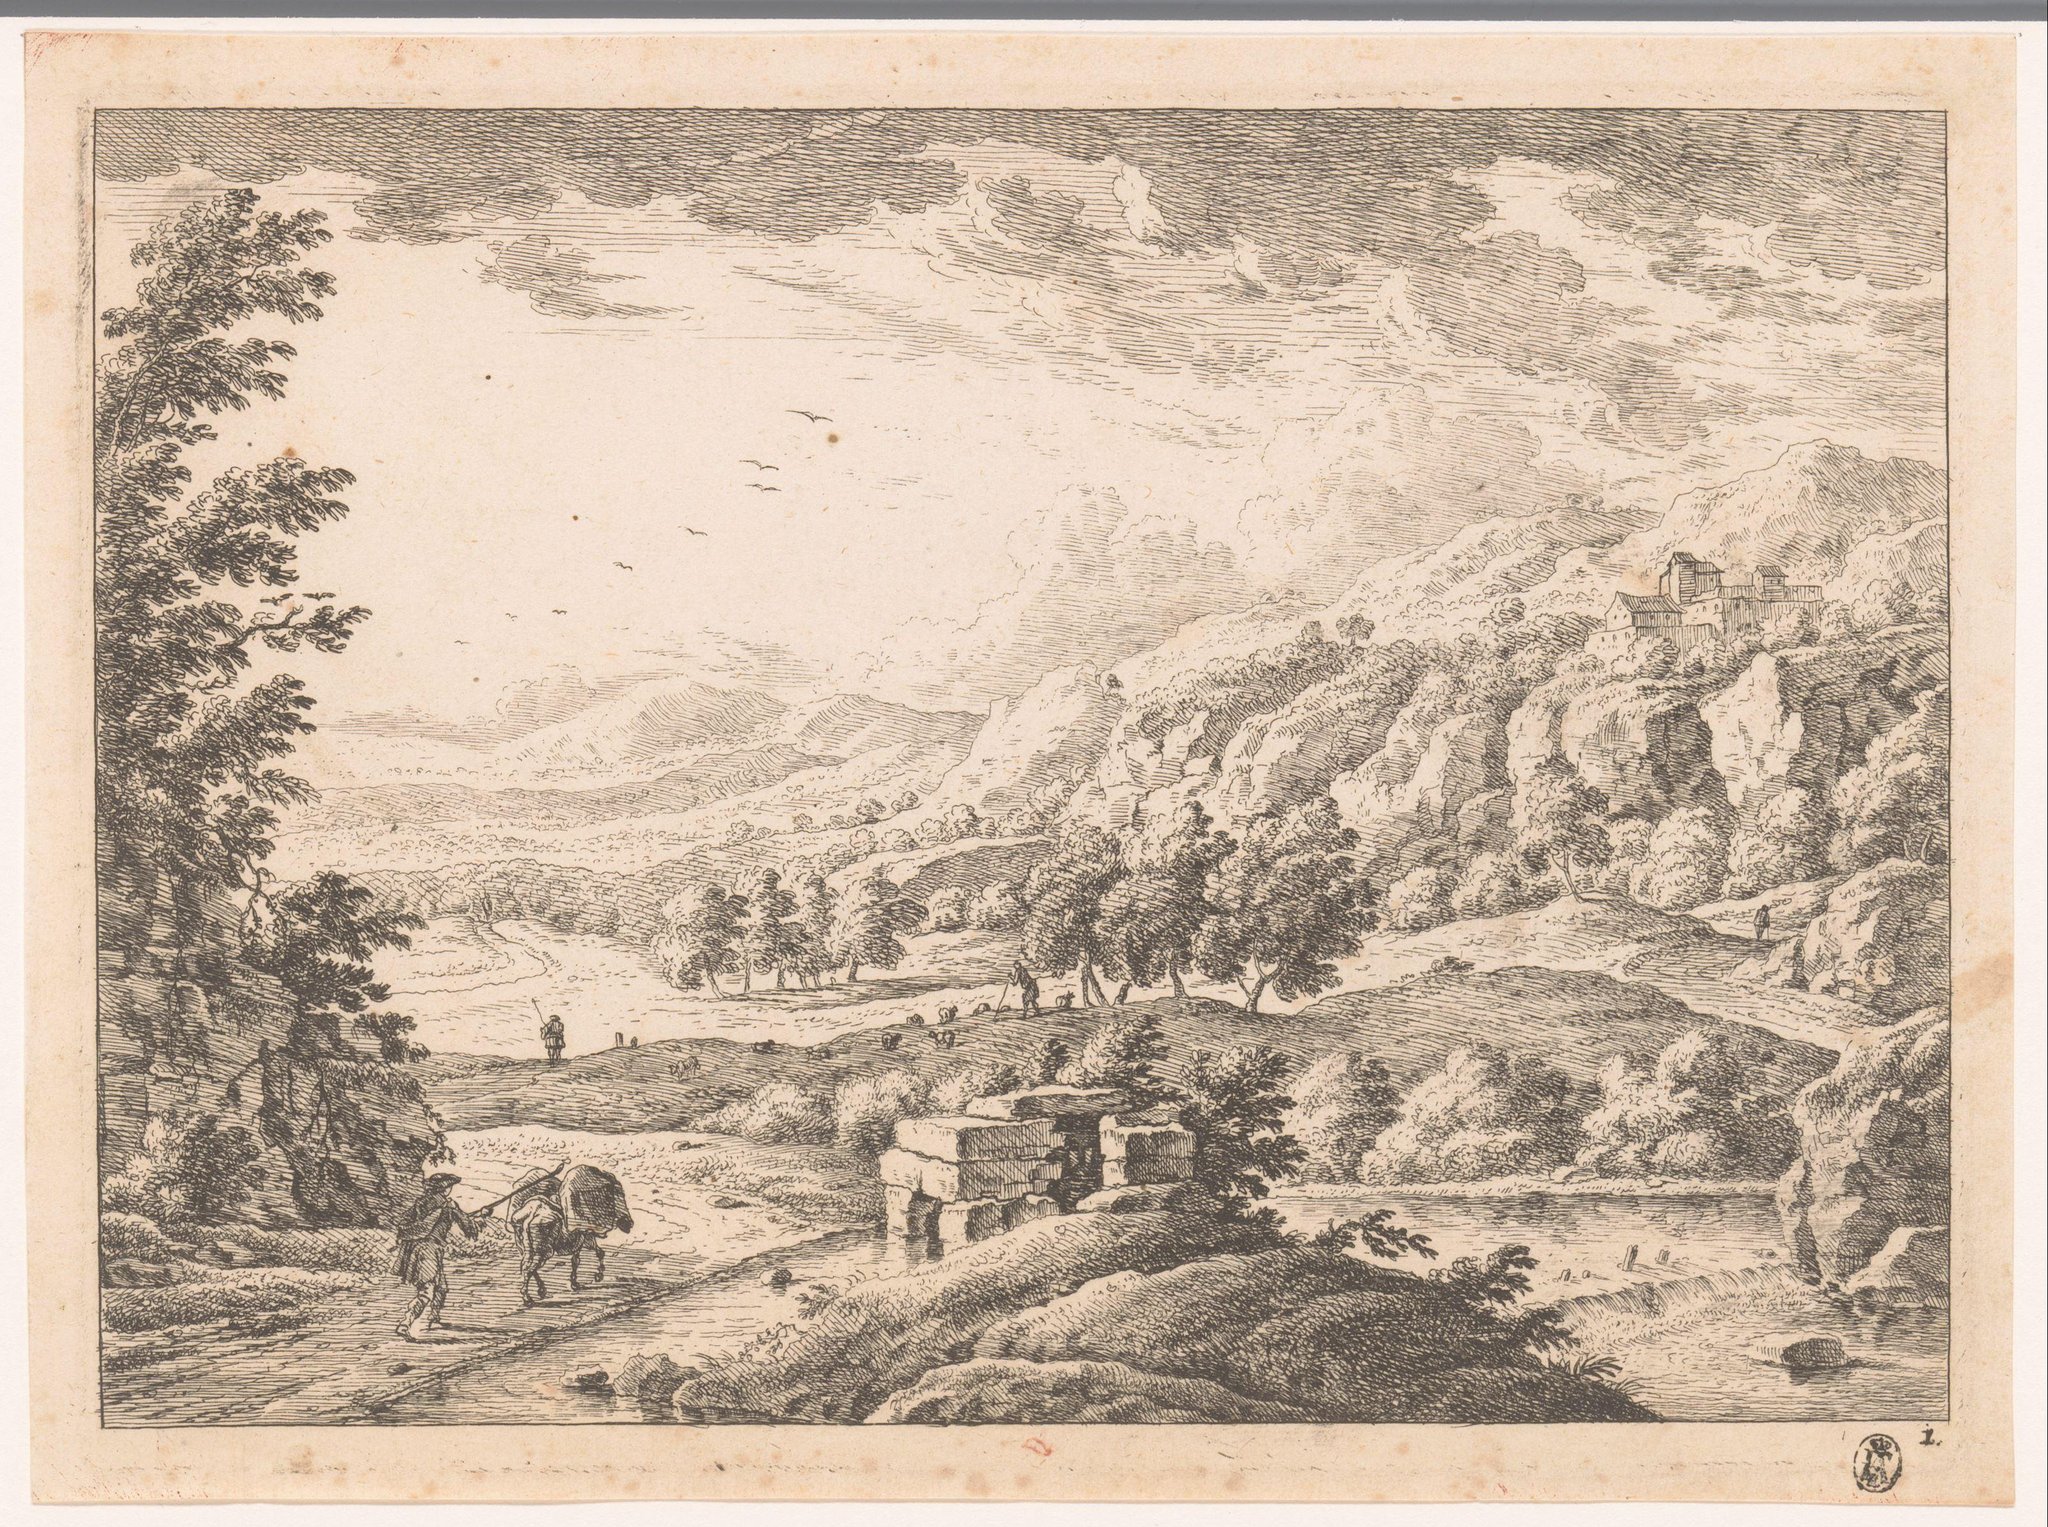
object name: print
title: Landschap met rivier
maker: monogrammist meg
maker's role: print maker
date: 1700-1730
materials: paper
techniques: etching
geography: germany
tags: river, animal mounts; pack-animals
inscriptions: collector's mark: Lugt 2760, collector's mark: Lugt 2228, collector's mark: Lugt 971